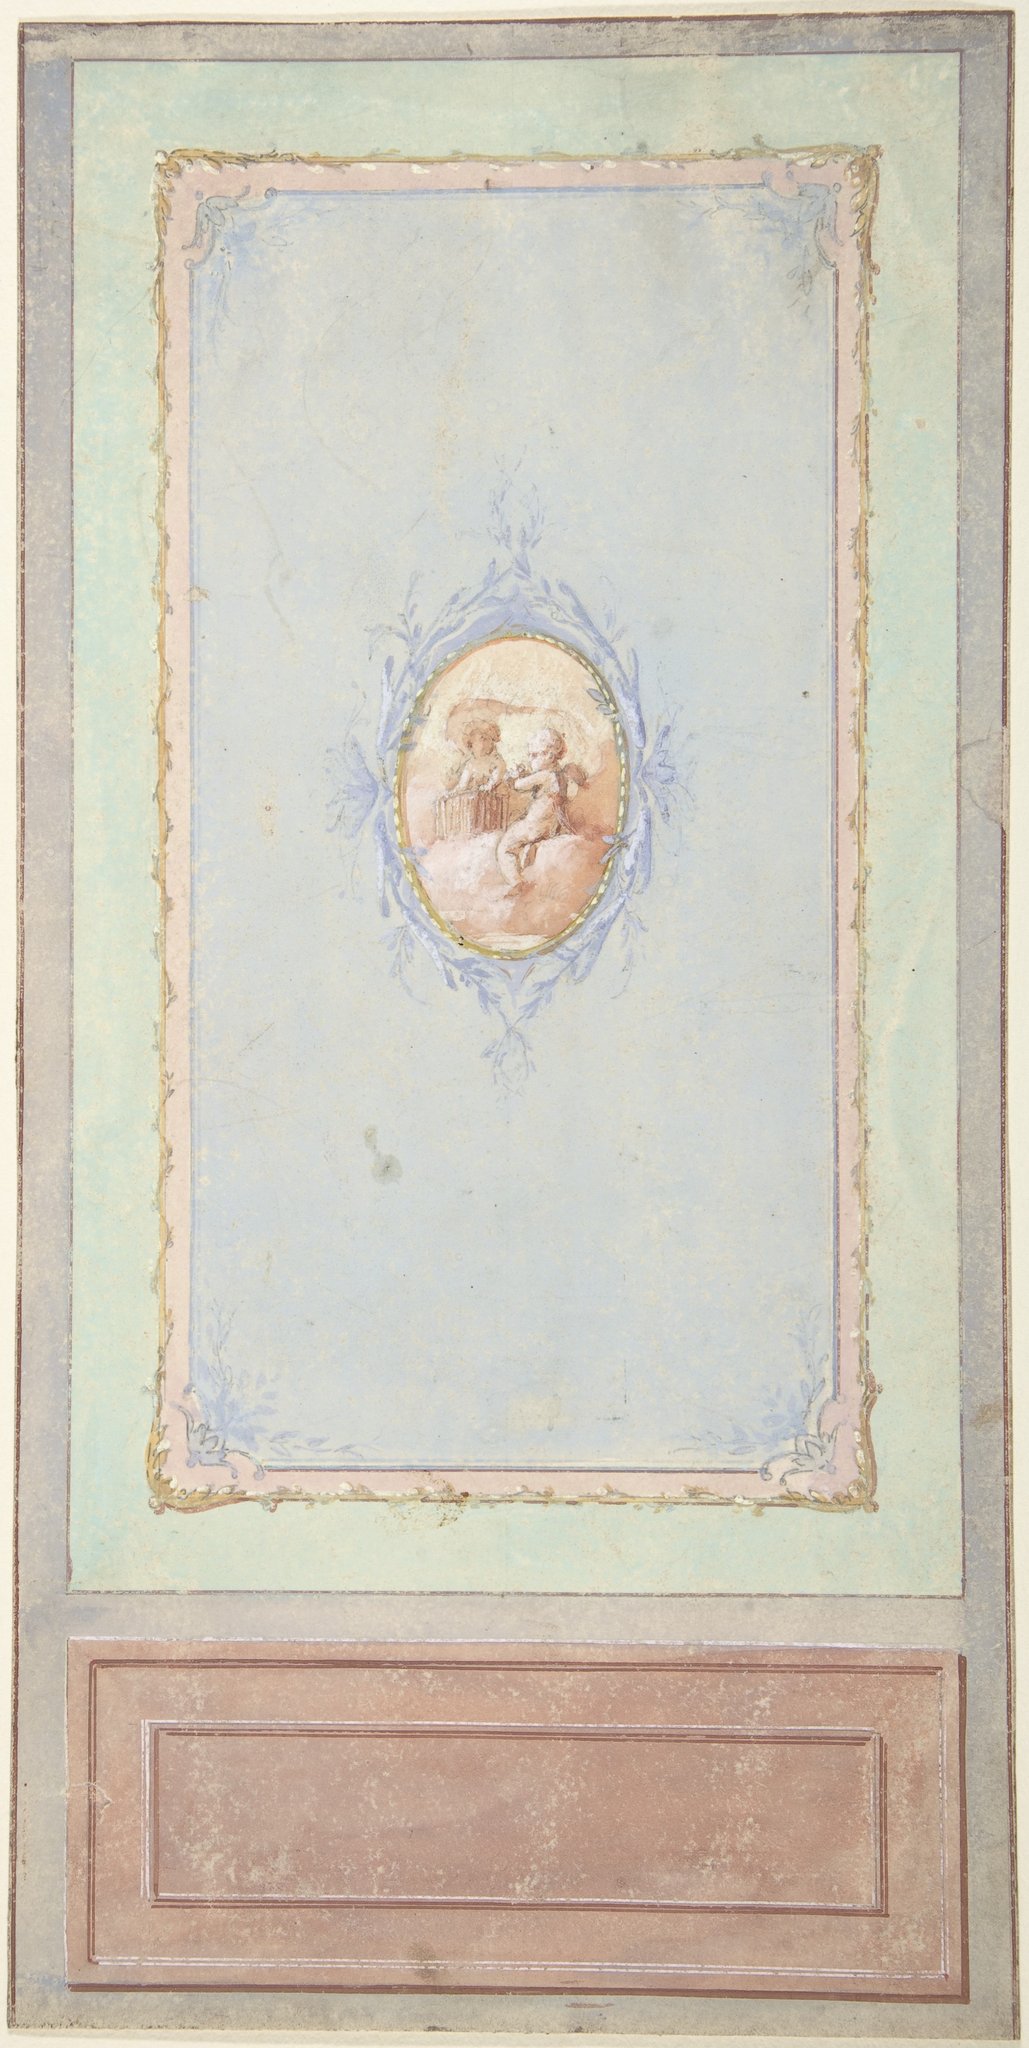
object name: drawing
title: Wall Panel Design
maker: anonymous, british, 19th century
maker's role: artist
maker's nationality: british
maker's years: 1800-1900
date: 1801-1900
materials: watercolor